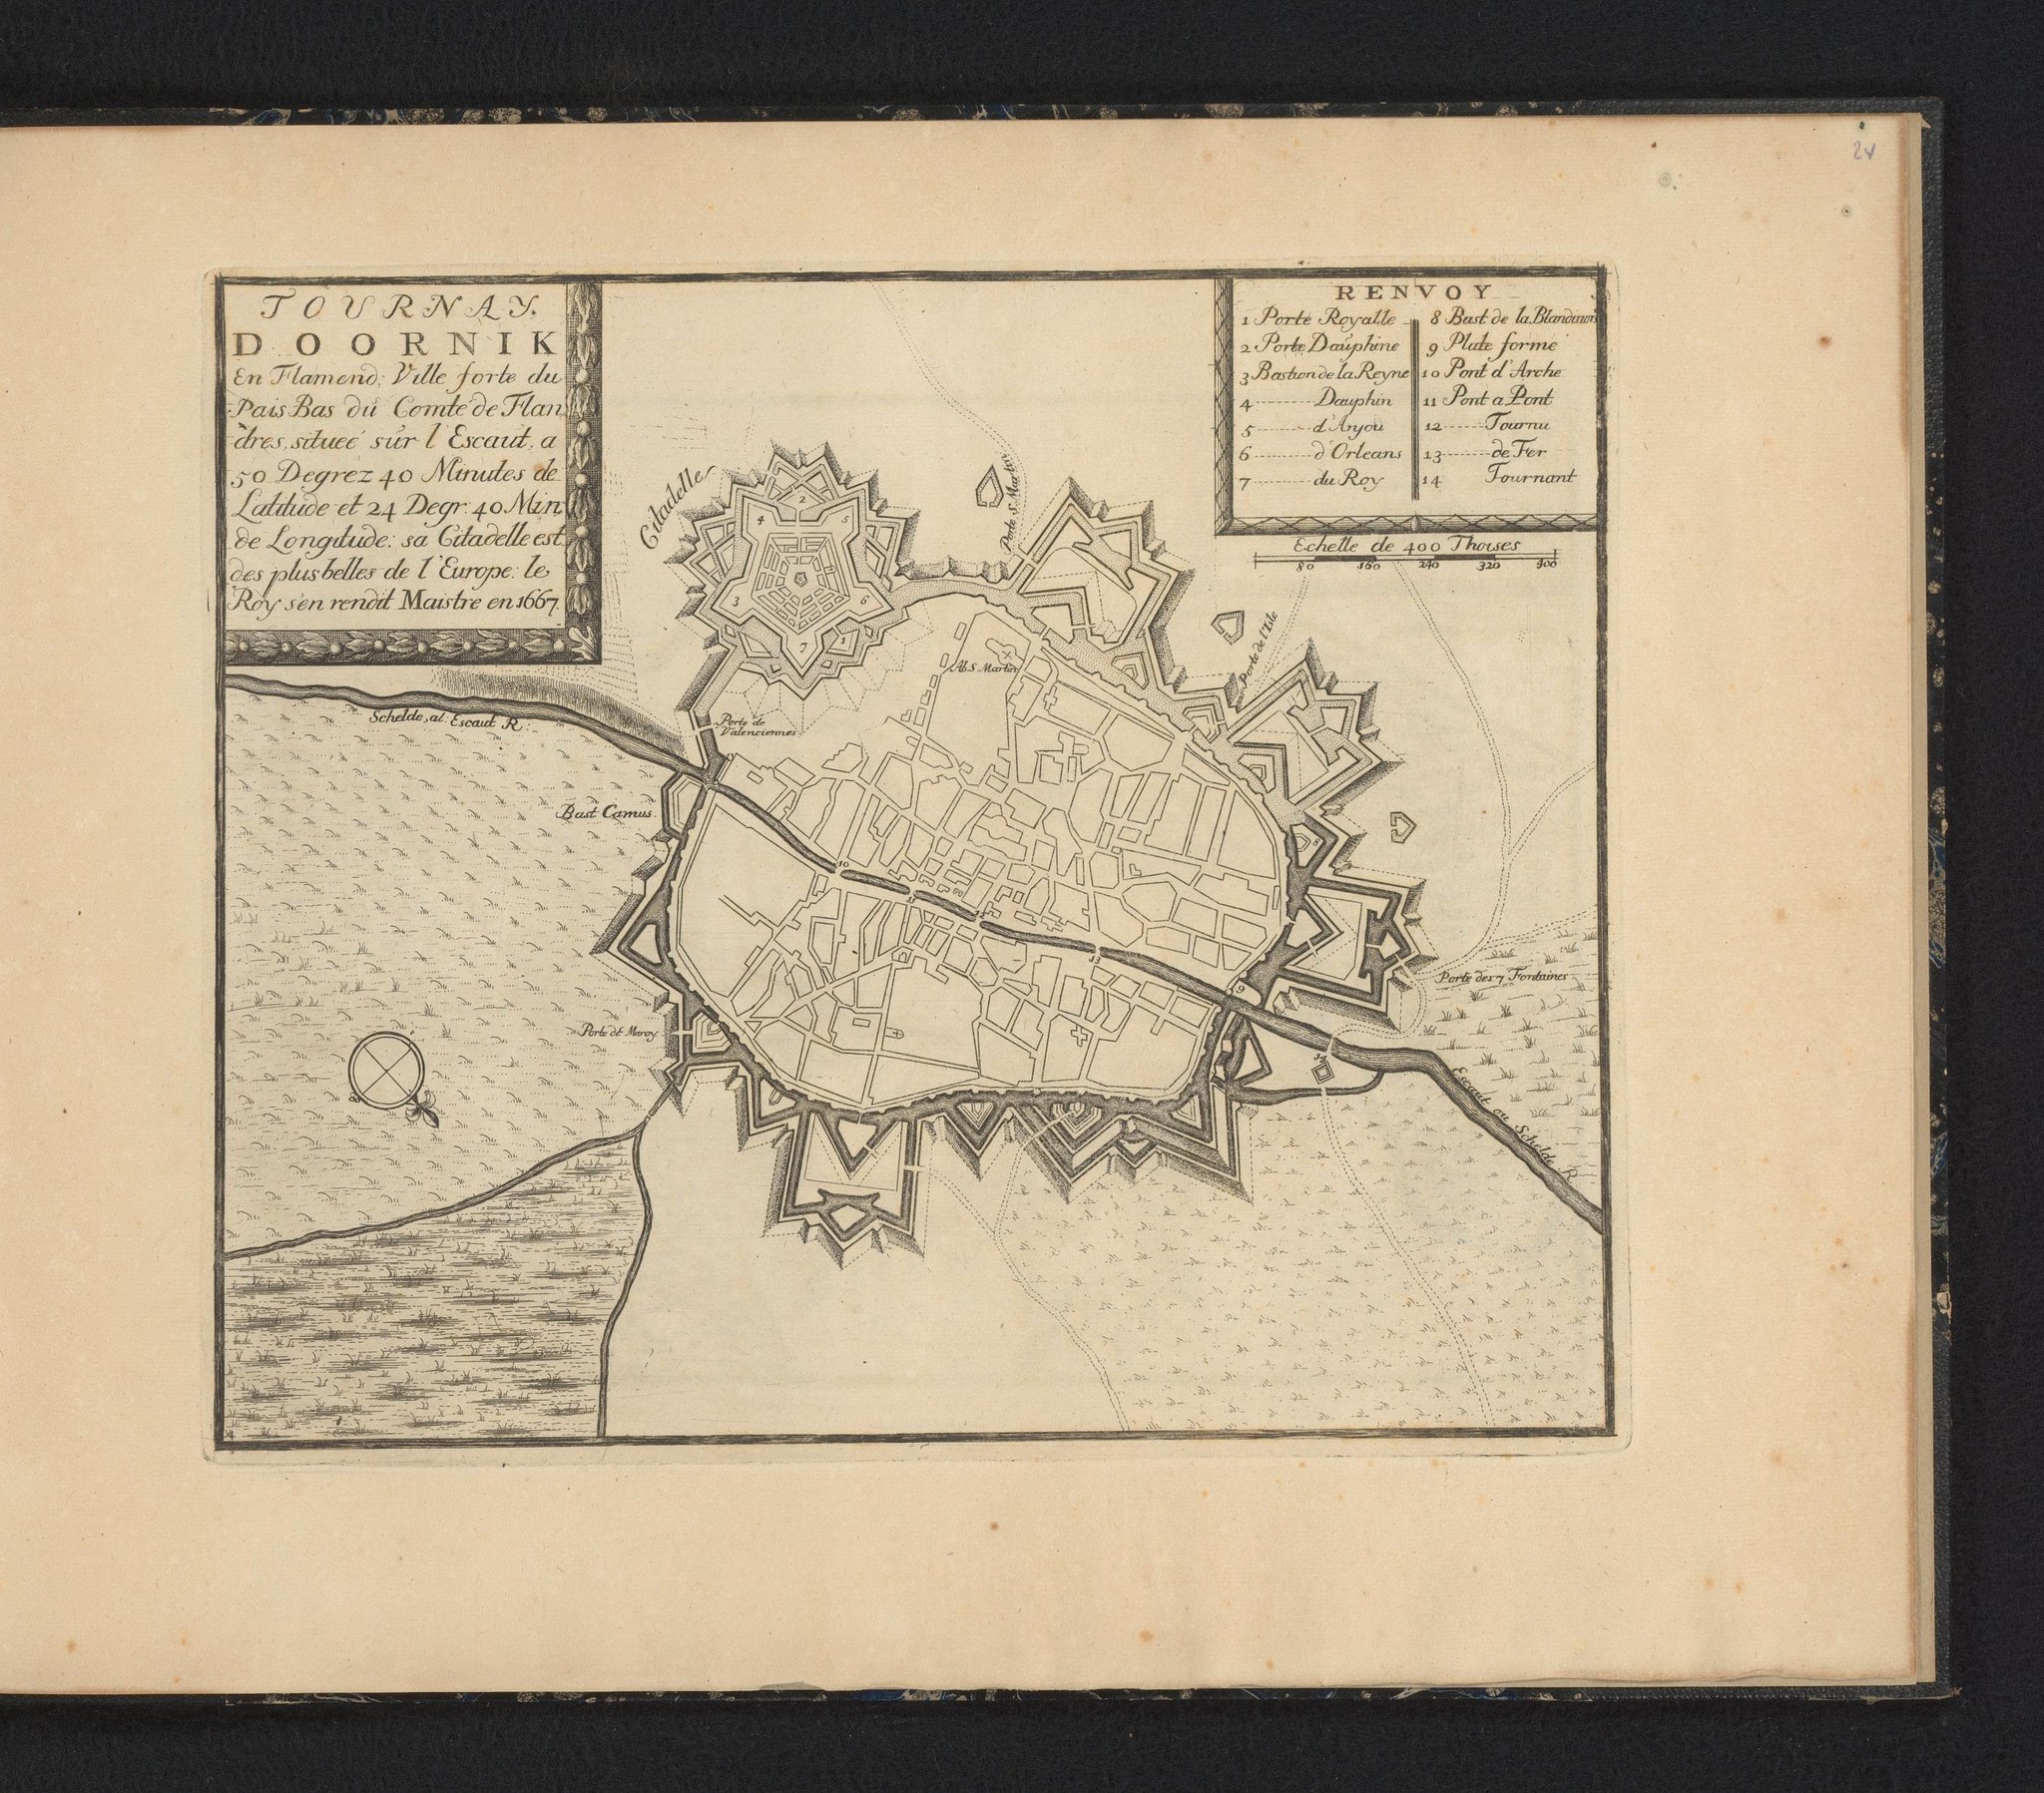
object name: map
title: Plattegrond van Tournai, ca. 1693-1696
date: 1693-1696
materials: paper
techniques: etching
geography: france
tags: fortress, maps of cities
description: Plattegrond van de versterkingen om de Vlaamse stad Tournai (Doornik). Maakt deel uit van het eerste deel van het prentwerk: Le Theatre de la Guerre, dans les Pays-Bas, uitgegeven in 1696. Dit deel bevat 25 platen met plannen (afkomstig van Sébastien Le Prestre, Seigneur de Vauban) van vermaarde sterke steden en vestingen in de Negenjarige Oorlog in de Nederlanden. Titel en opschriften in het Frans.